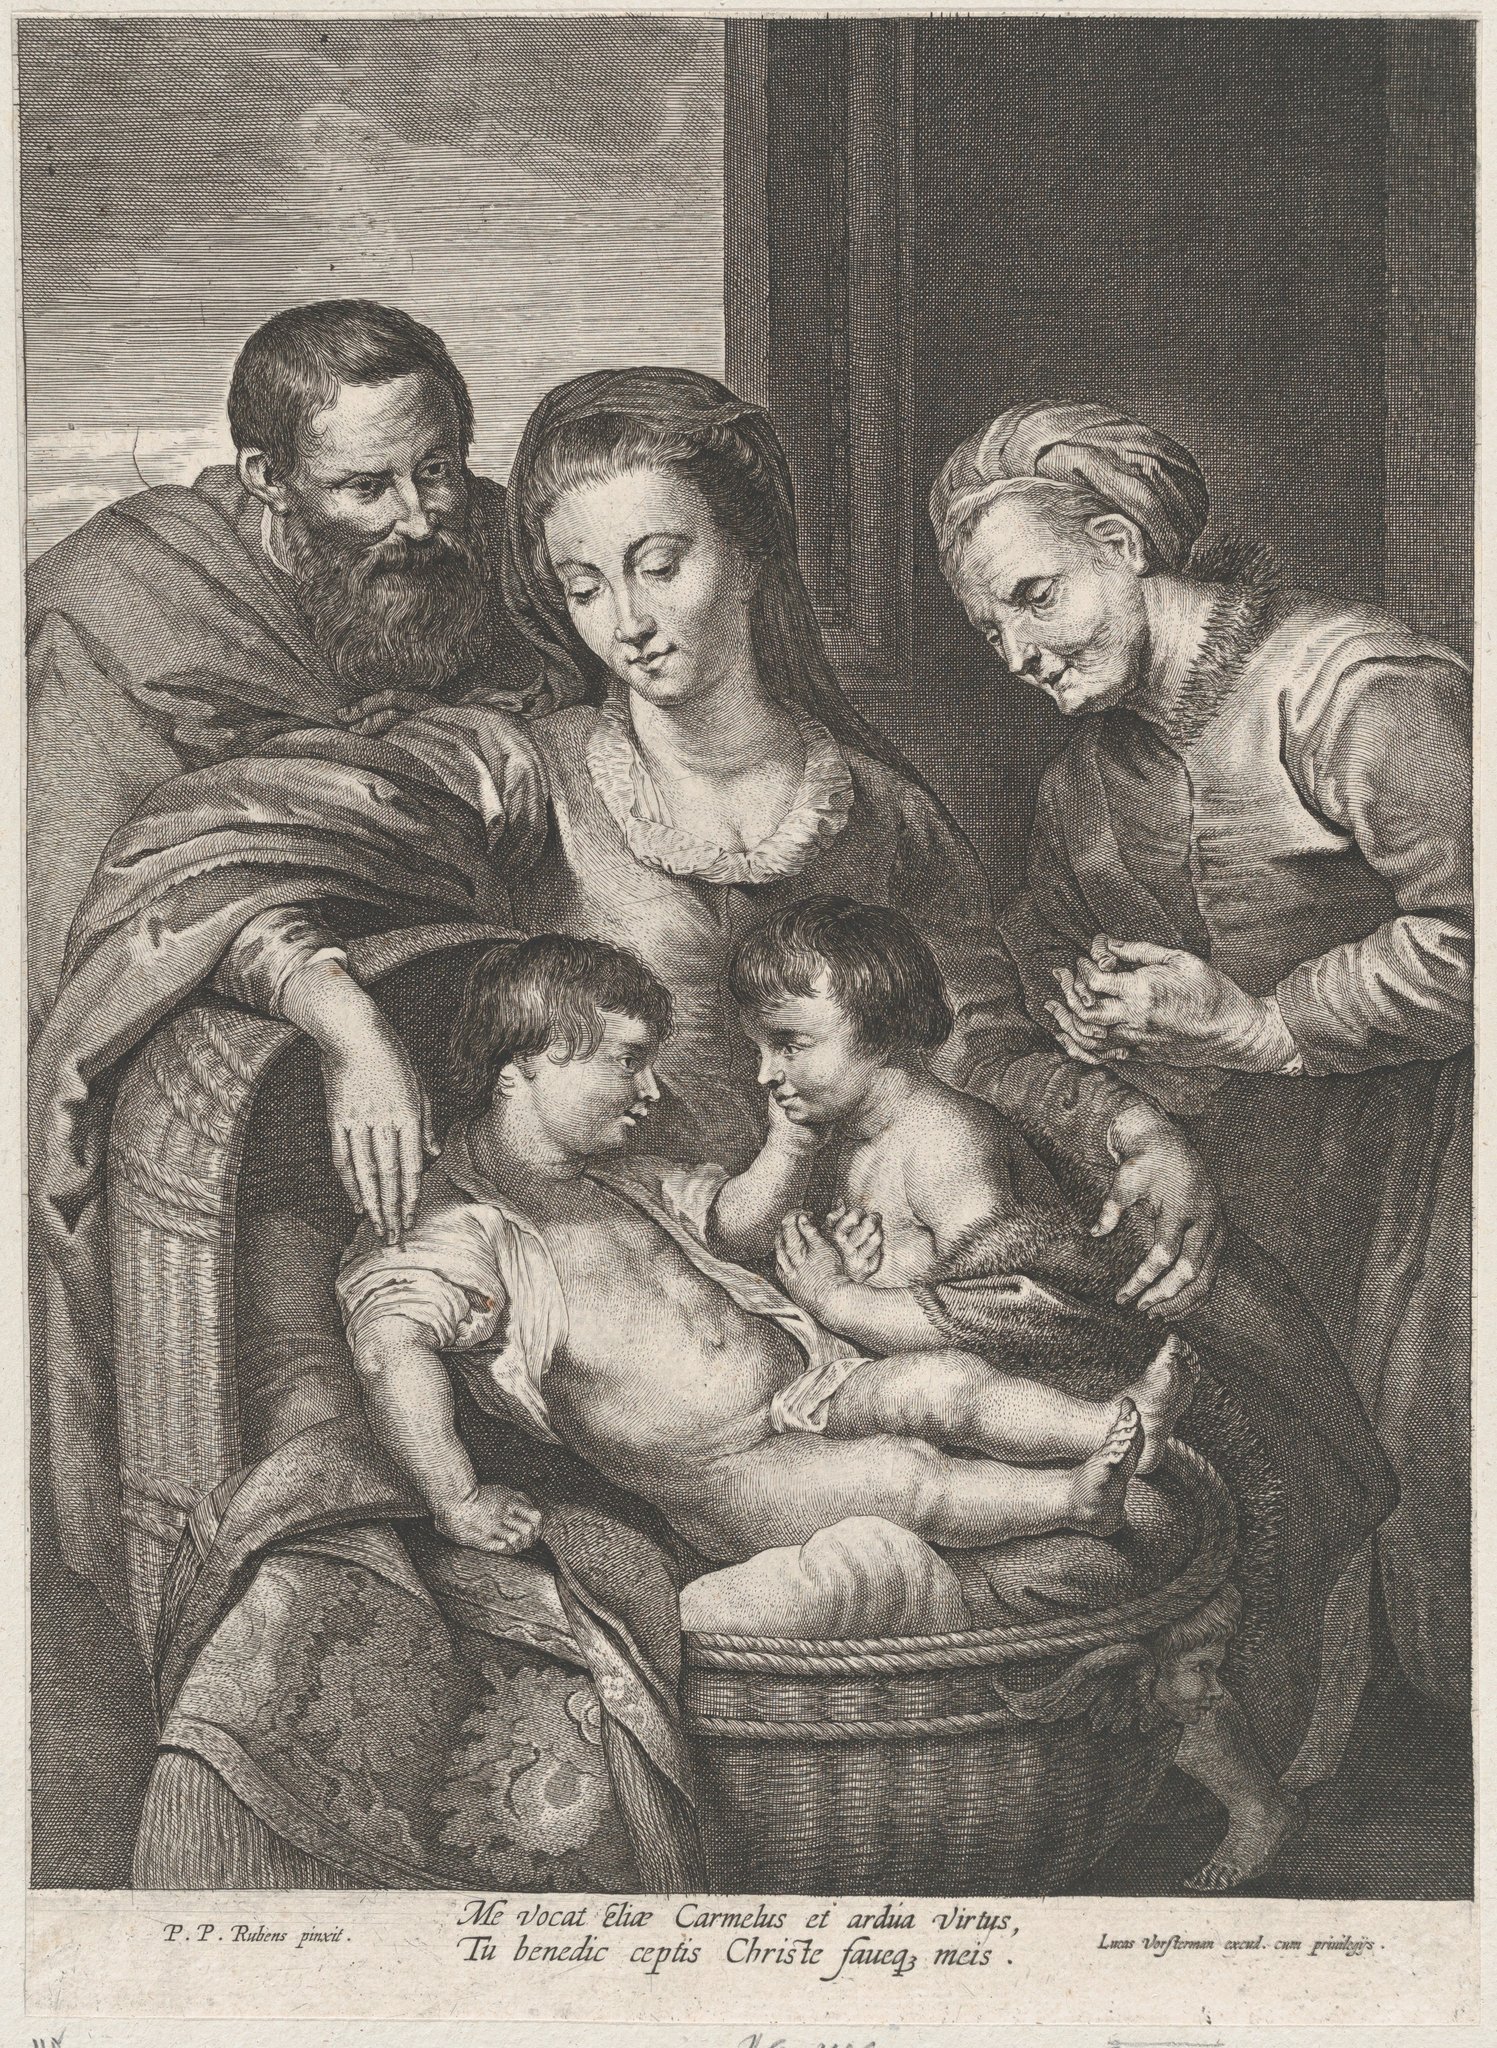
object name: print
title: The Holy Family with Saint Elizabeth and the infant Saint John the Baptist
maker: lucas vorsterman (i)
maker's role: artist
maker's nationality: flemish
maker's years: 1595-1675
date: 1615-1675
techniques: engraving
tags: holy family,saint john the baptist,jesus,saints